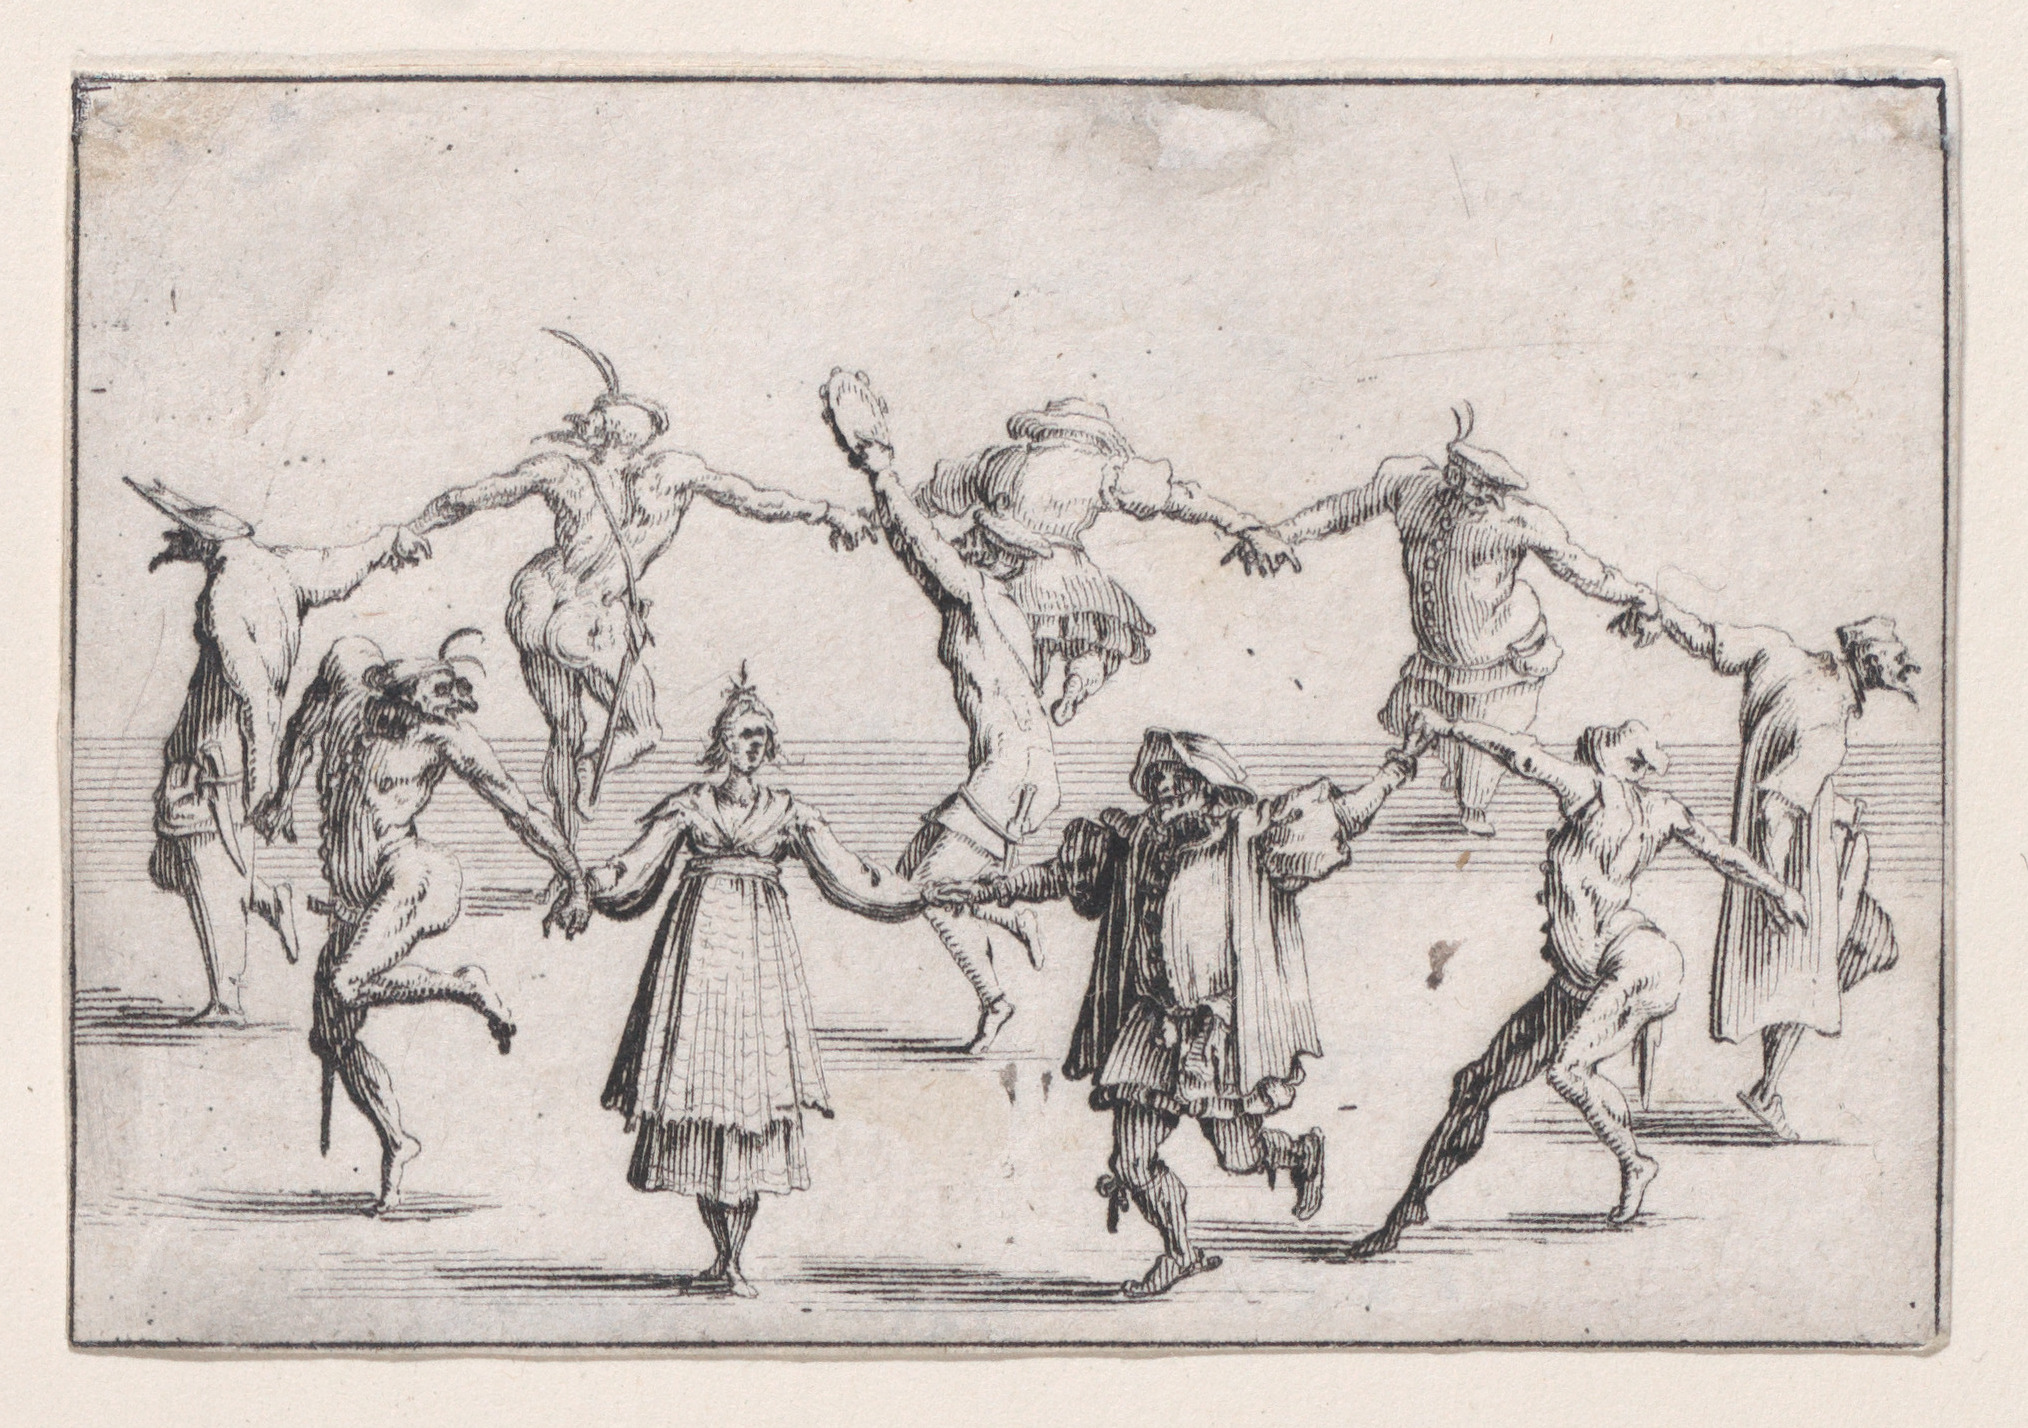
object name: print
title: La Ronde (The Round Dance), from "Les Caprices" Series A, The Florence Set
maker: jacques callot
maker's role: artist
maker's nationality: french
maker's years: 1592-1635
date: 1617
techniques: etching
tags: men,women,dancing